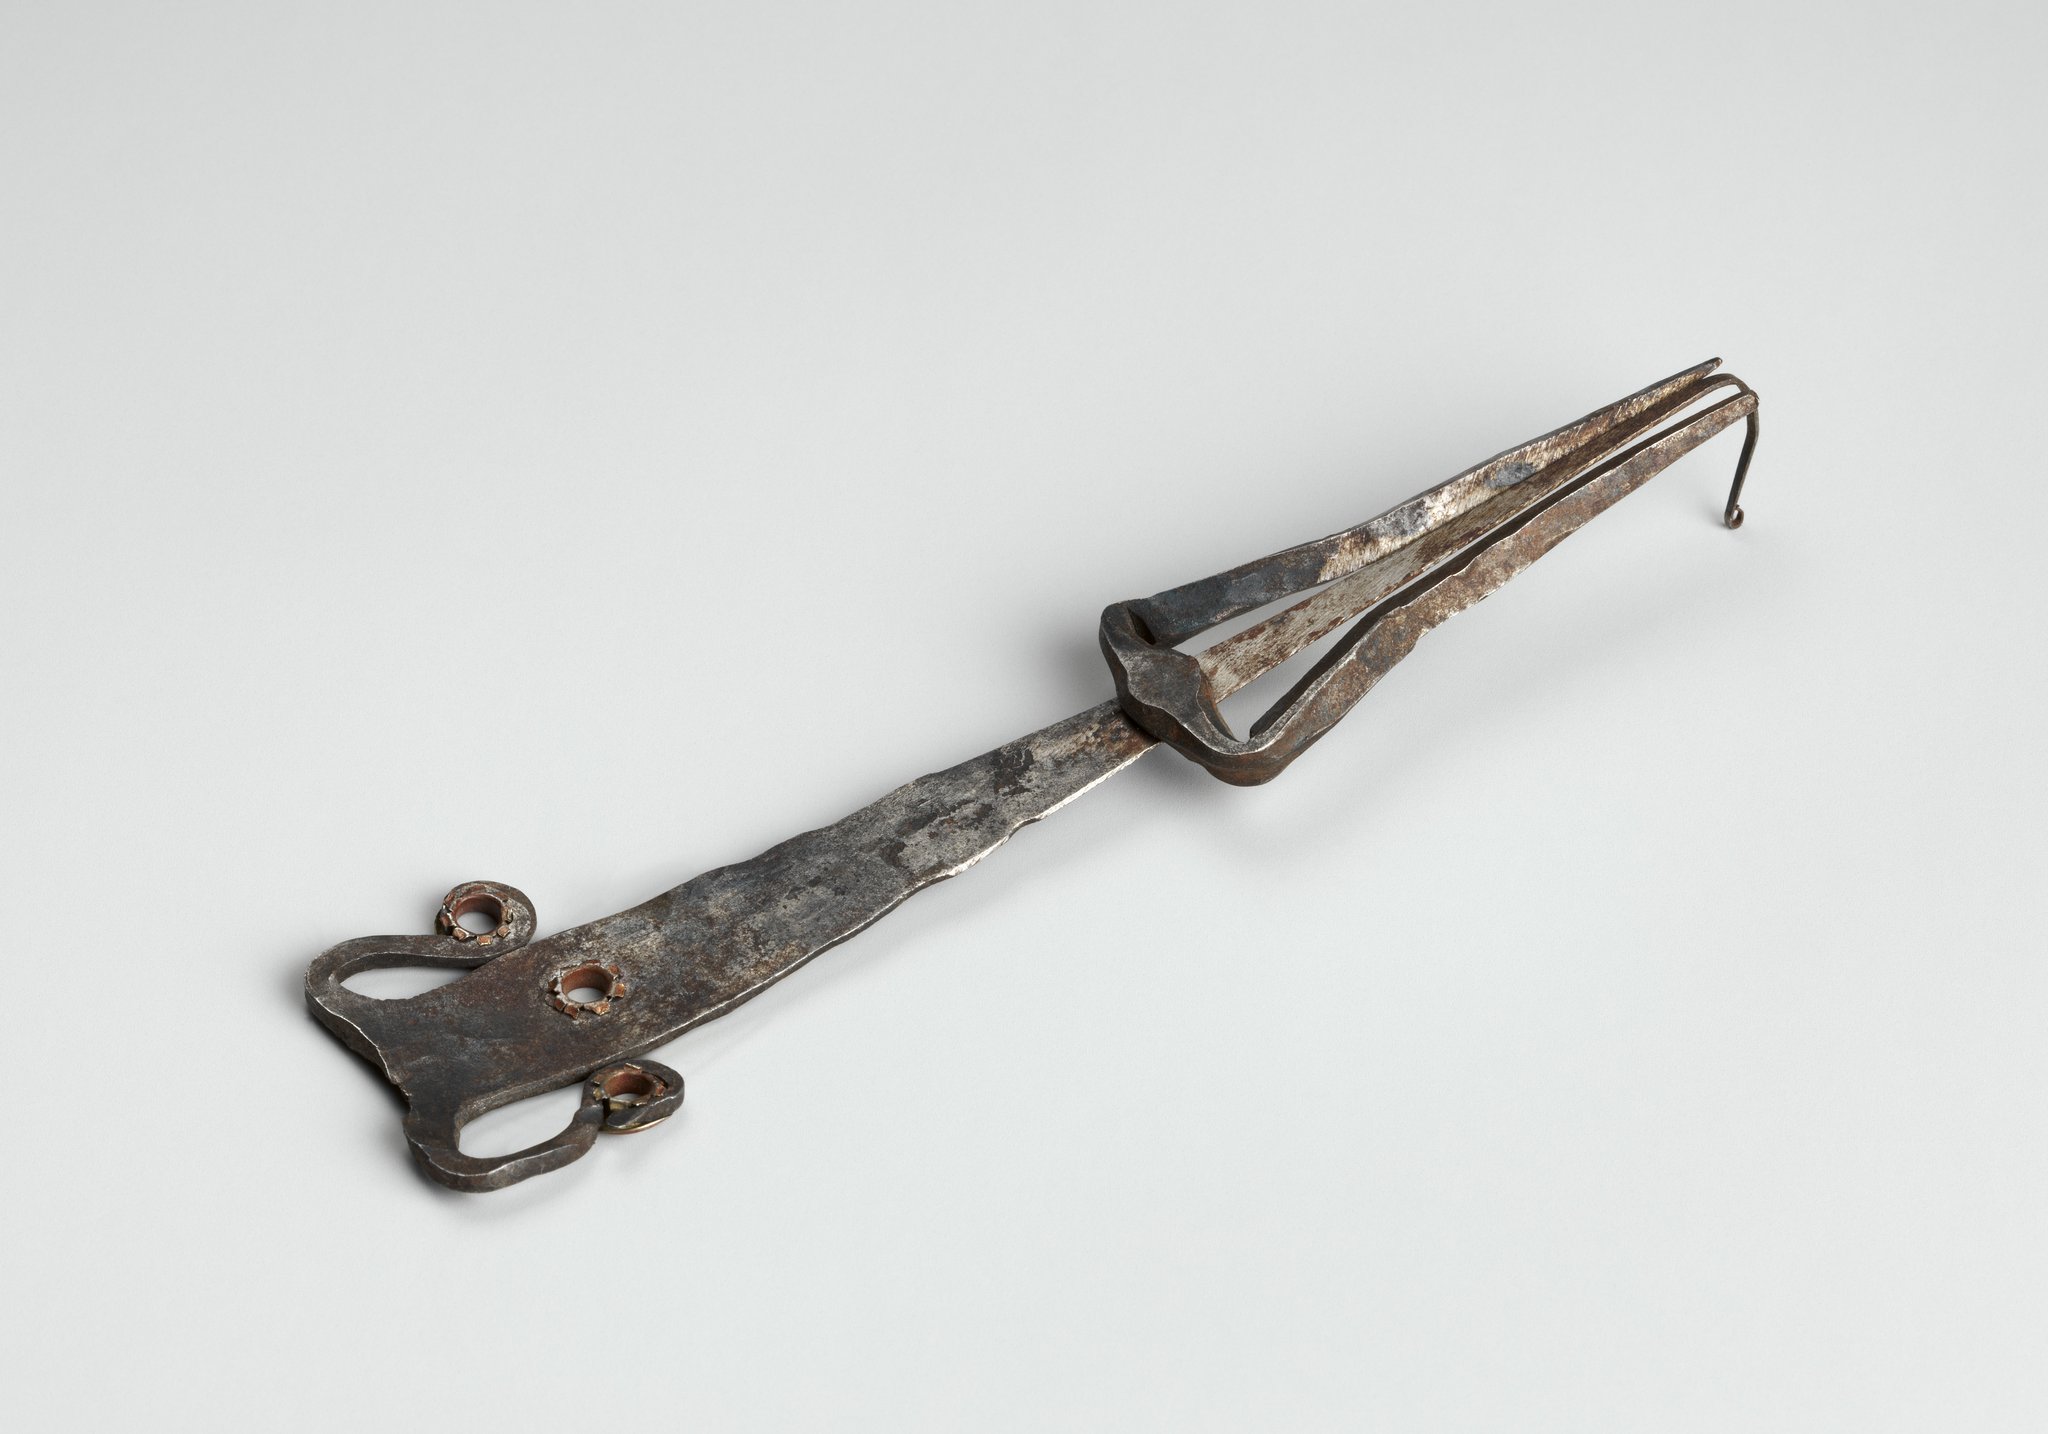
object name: chang jaw harp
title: Chang (jaw harp)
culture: afghan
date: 1934-1966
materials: iron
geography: afghanistan